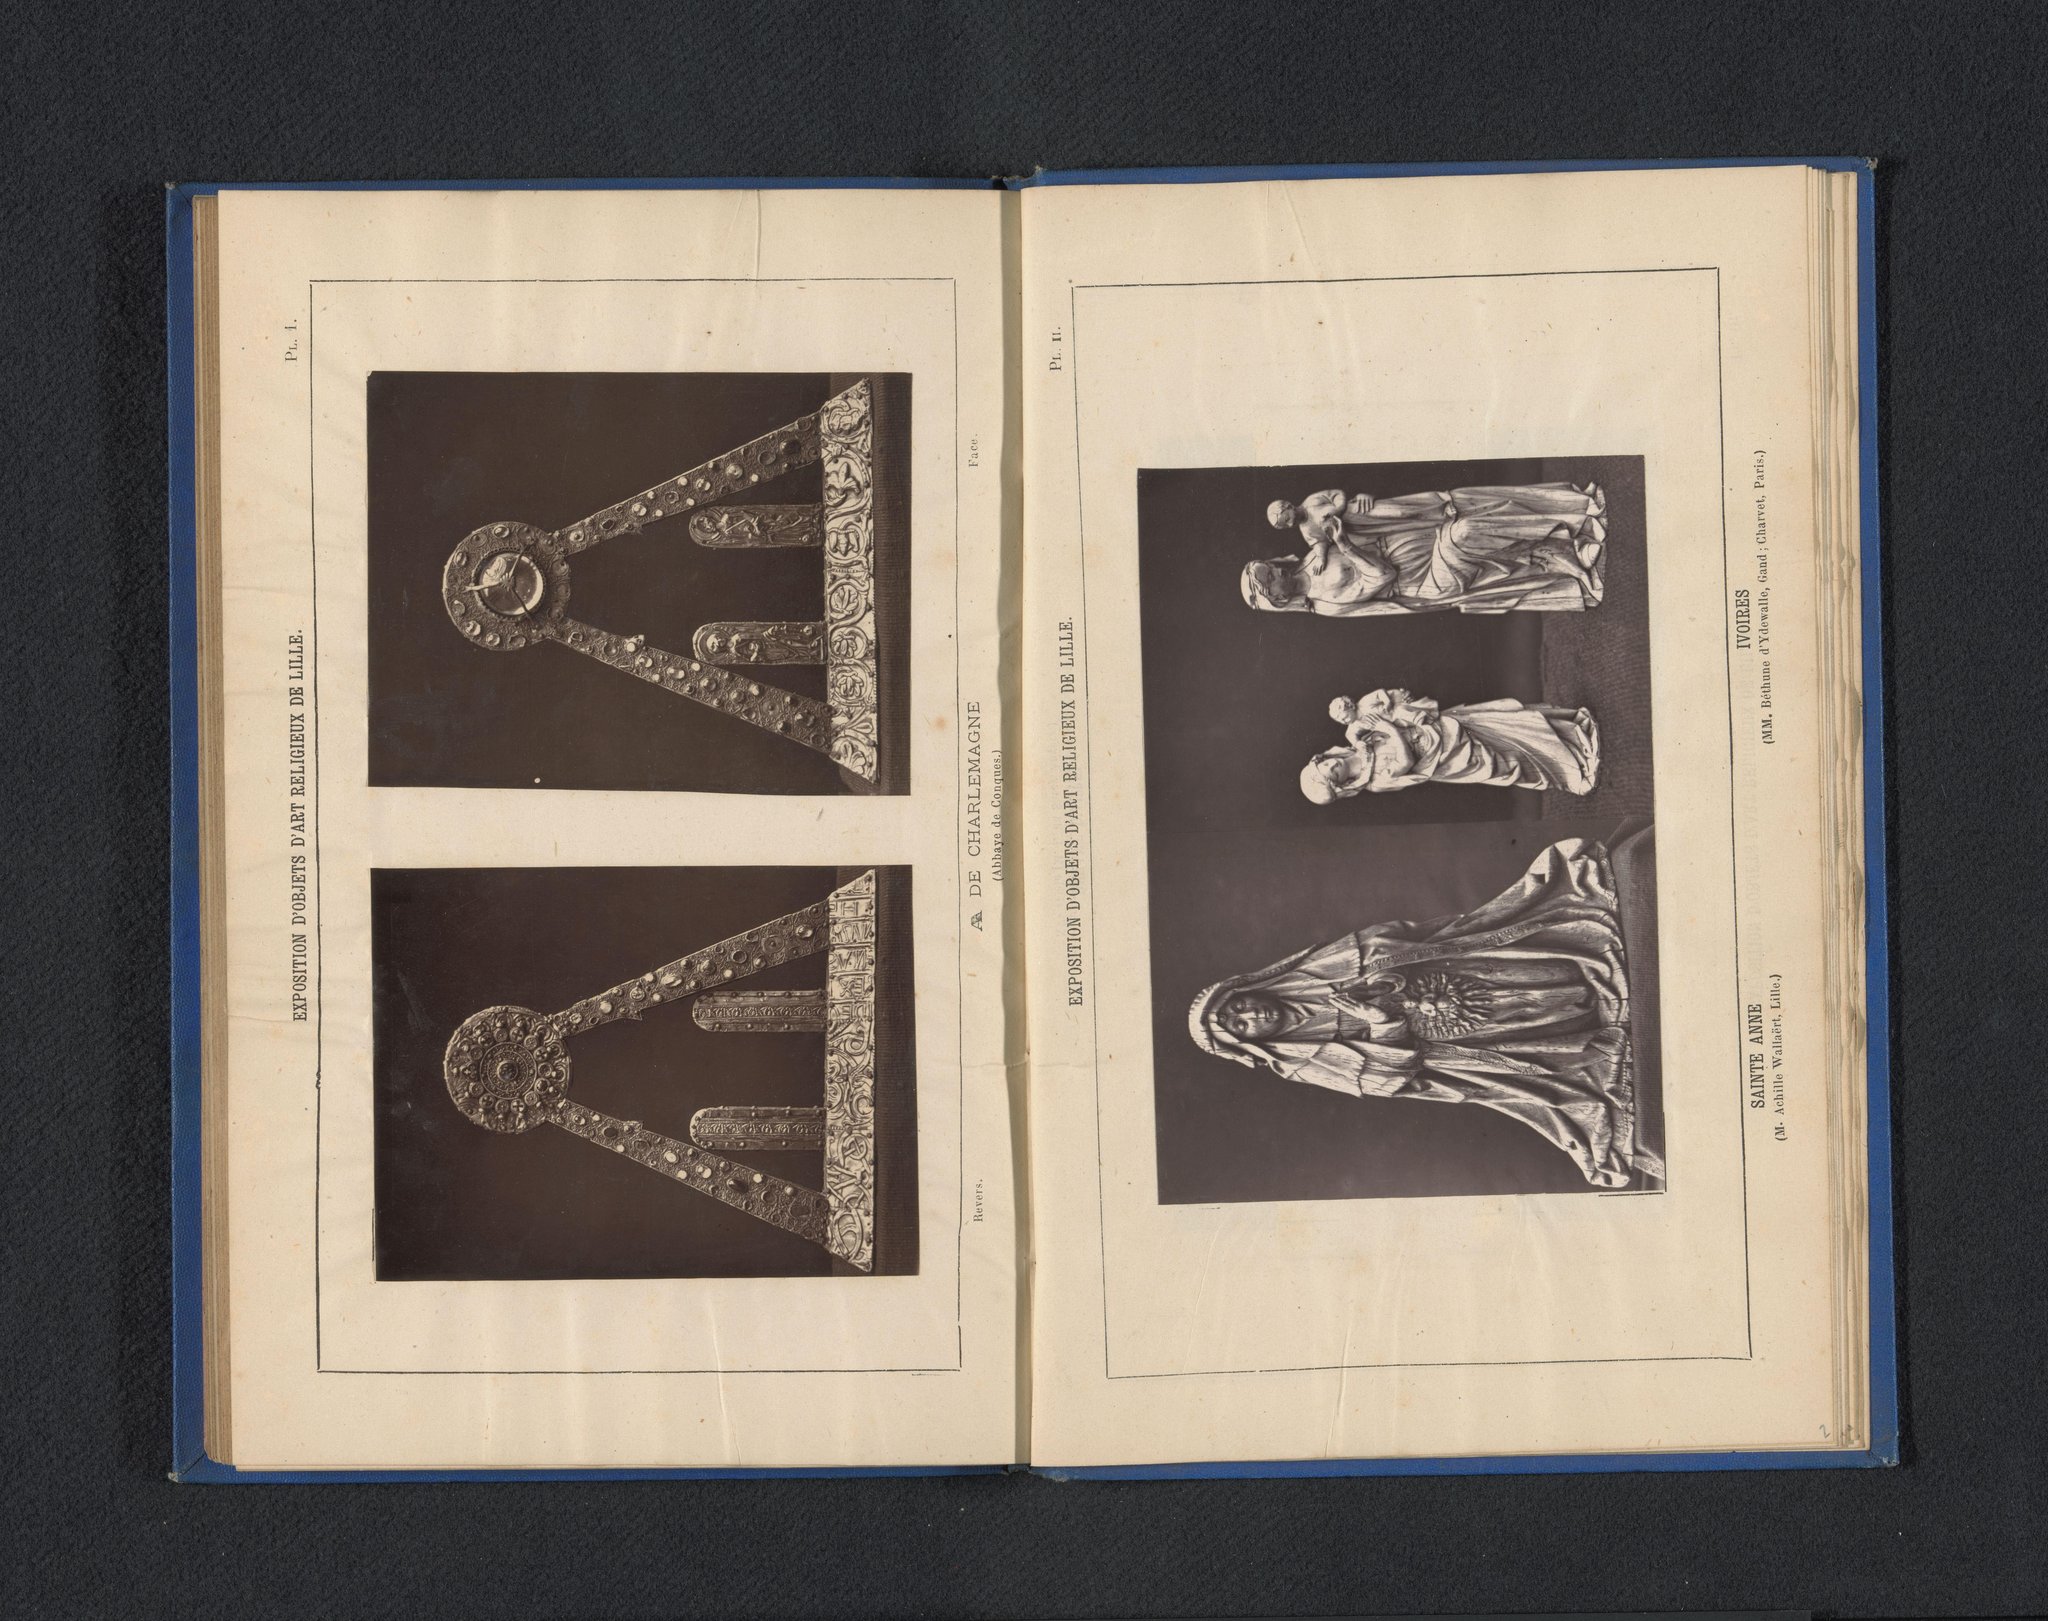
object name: photomechanical print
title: A de Charlemagne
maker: Anonymous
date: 1871-1876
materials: cardboard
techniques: woodburytype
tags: relics (and reliquaries)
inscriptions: inscription: ‘Pl. 1.’, inscription: ‘Exposition d'objets d'art religieux de Lille’, inscription: ‘revers/ Face/ (Abbaye de Conques.)’